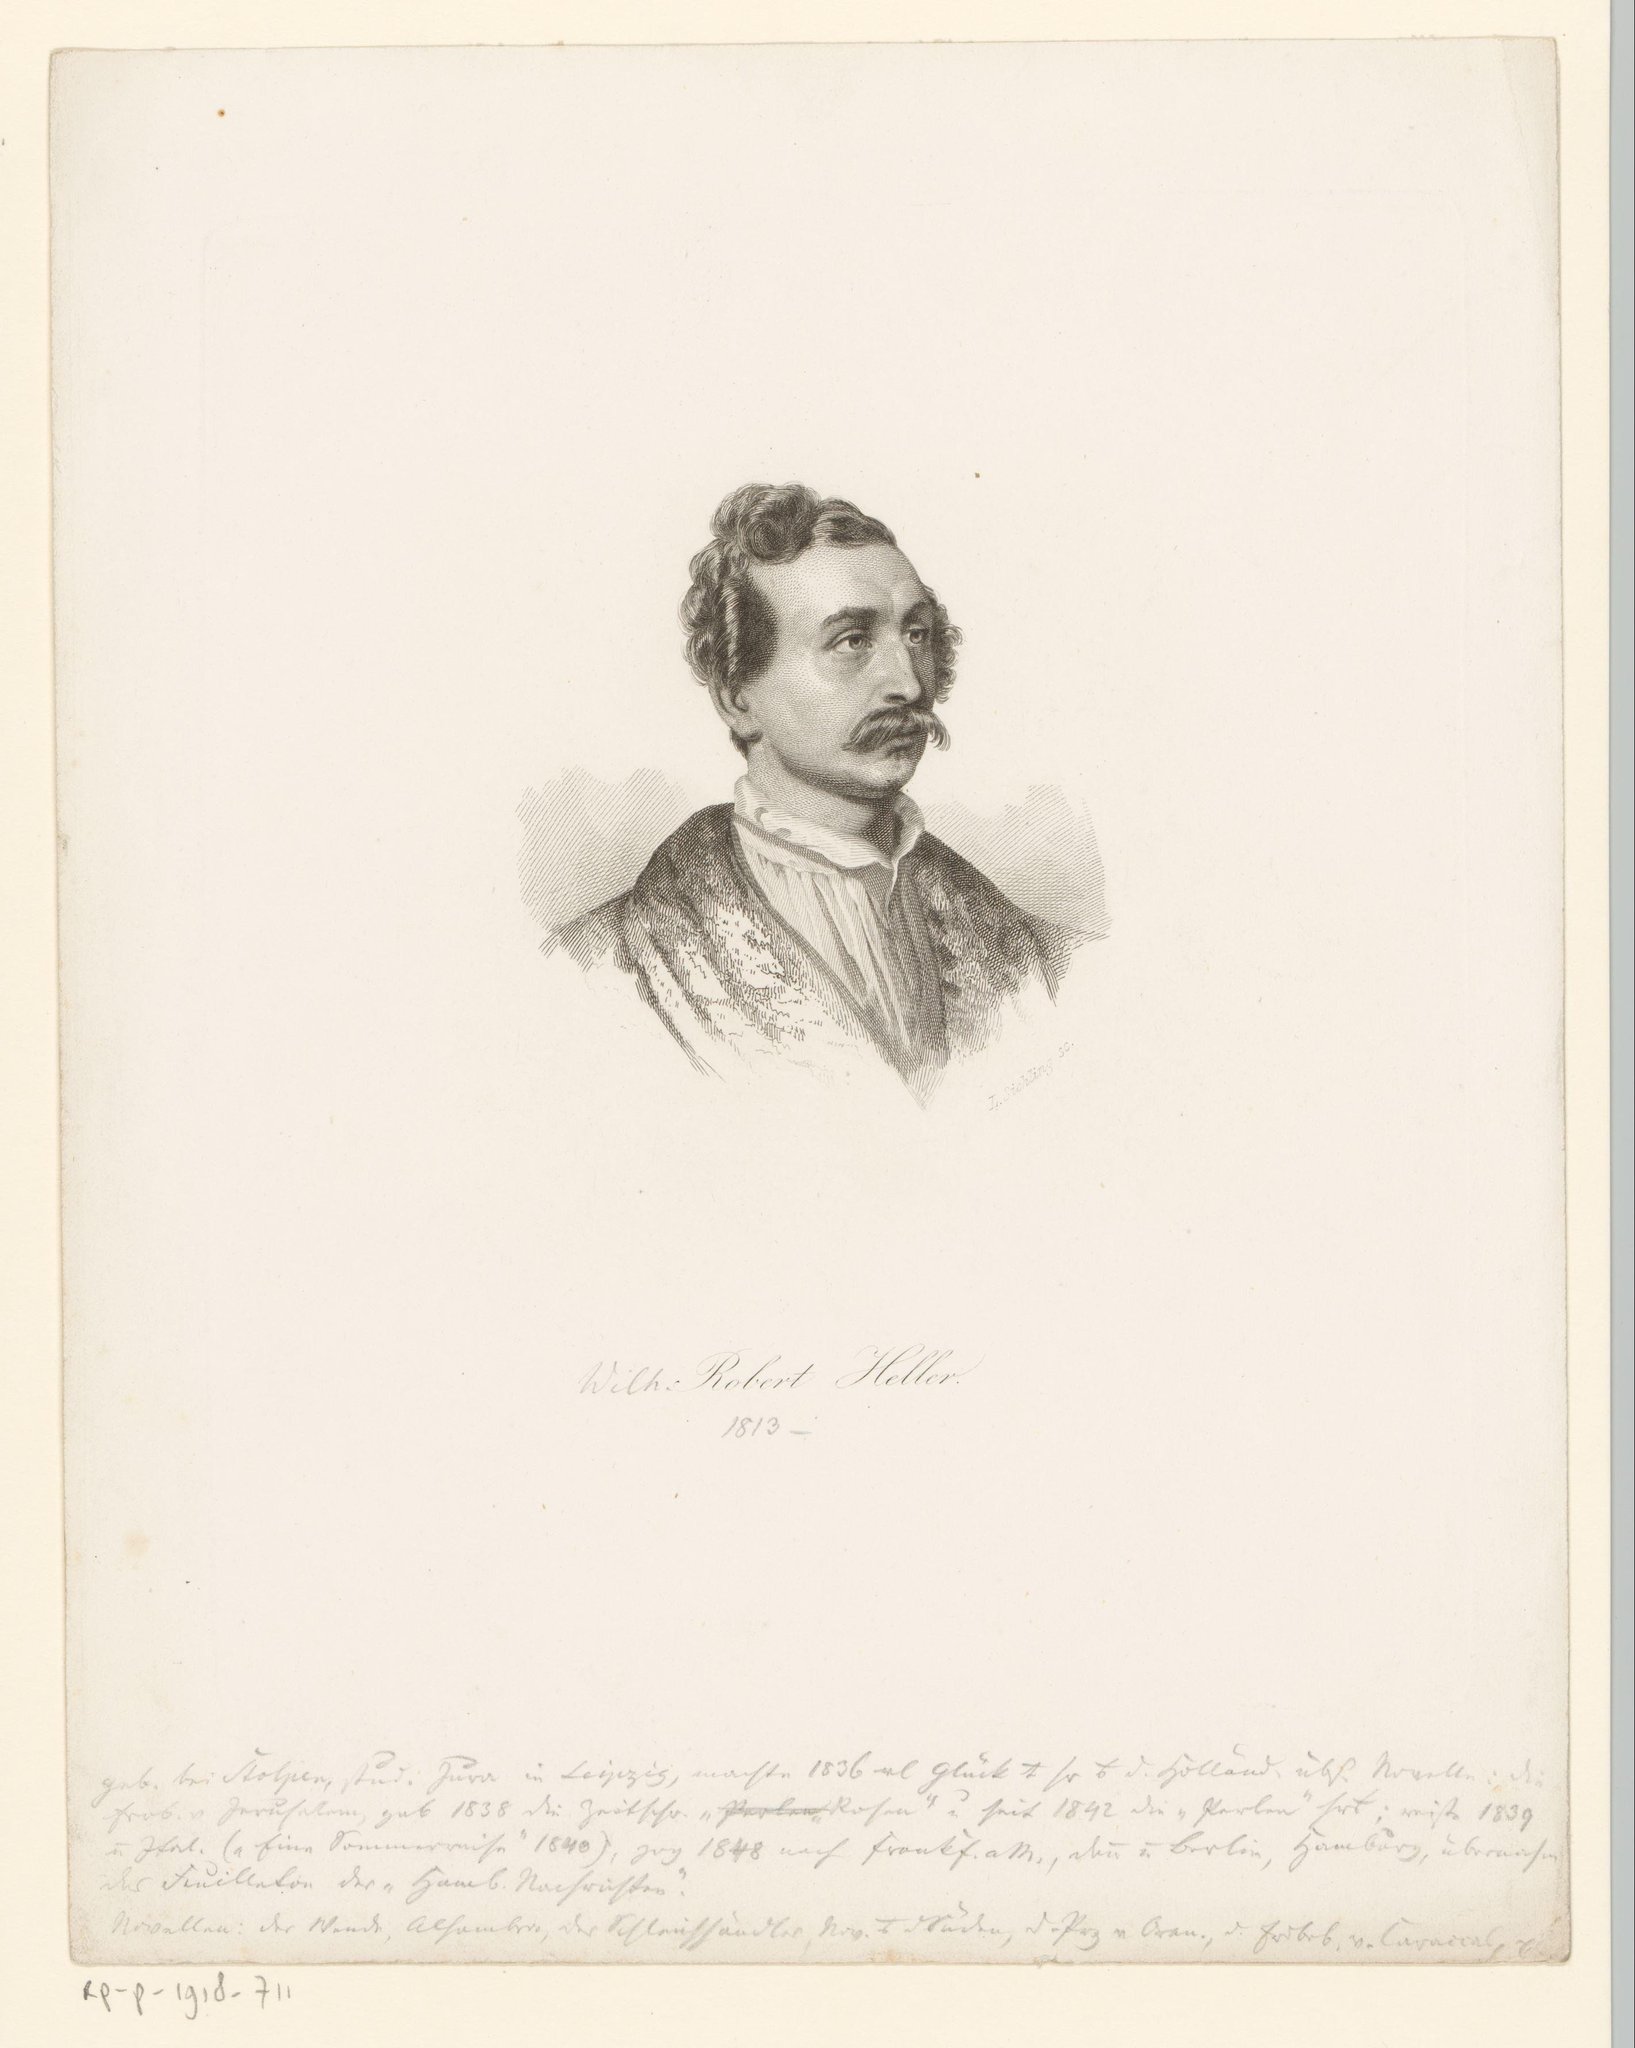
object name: print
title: Portret van Wilhelm Robert Heller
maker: lazarus gottlieb sichling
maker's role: print maker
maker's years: 1812-1863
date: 1829-1863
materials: paper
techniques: engraving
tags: historical persons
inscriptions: collector's mark: Lugt 2233